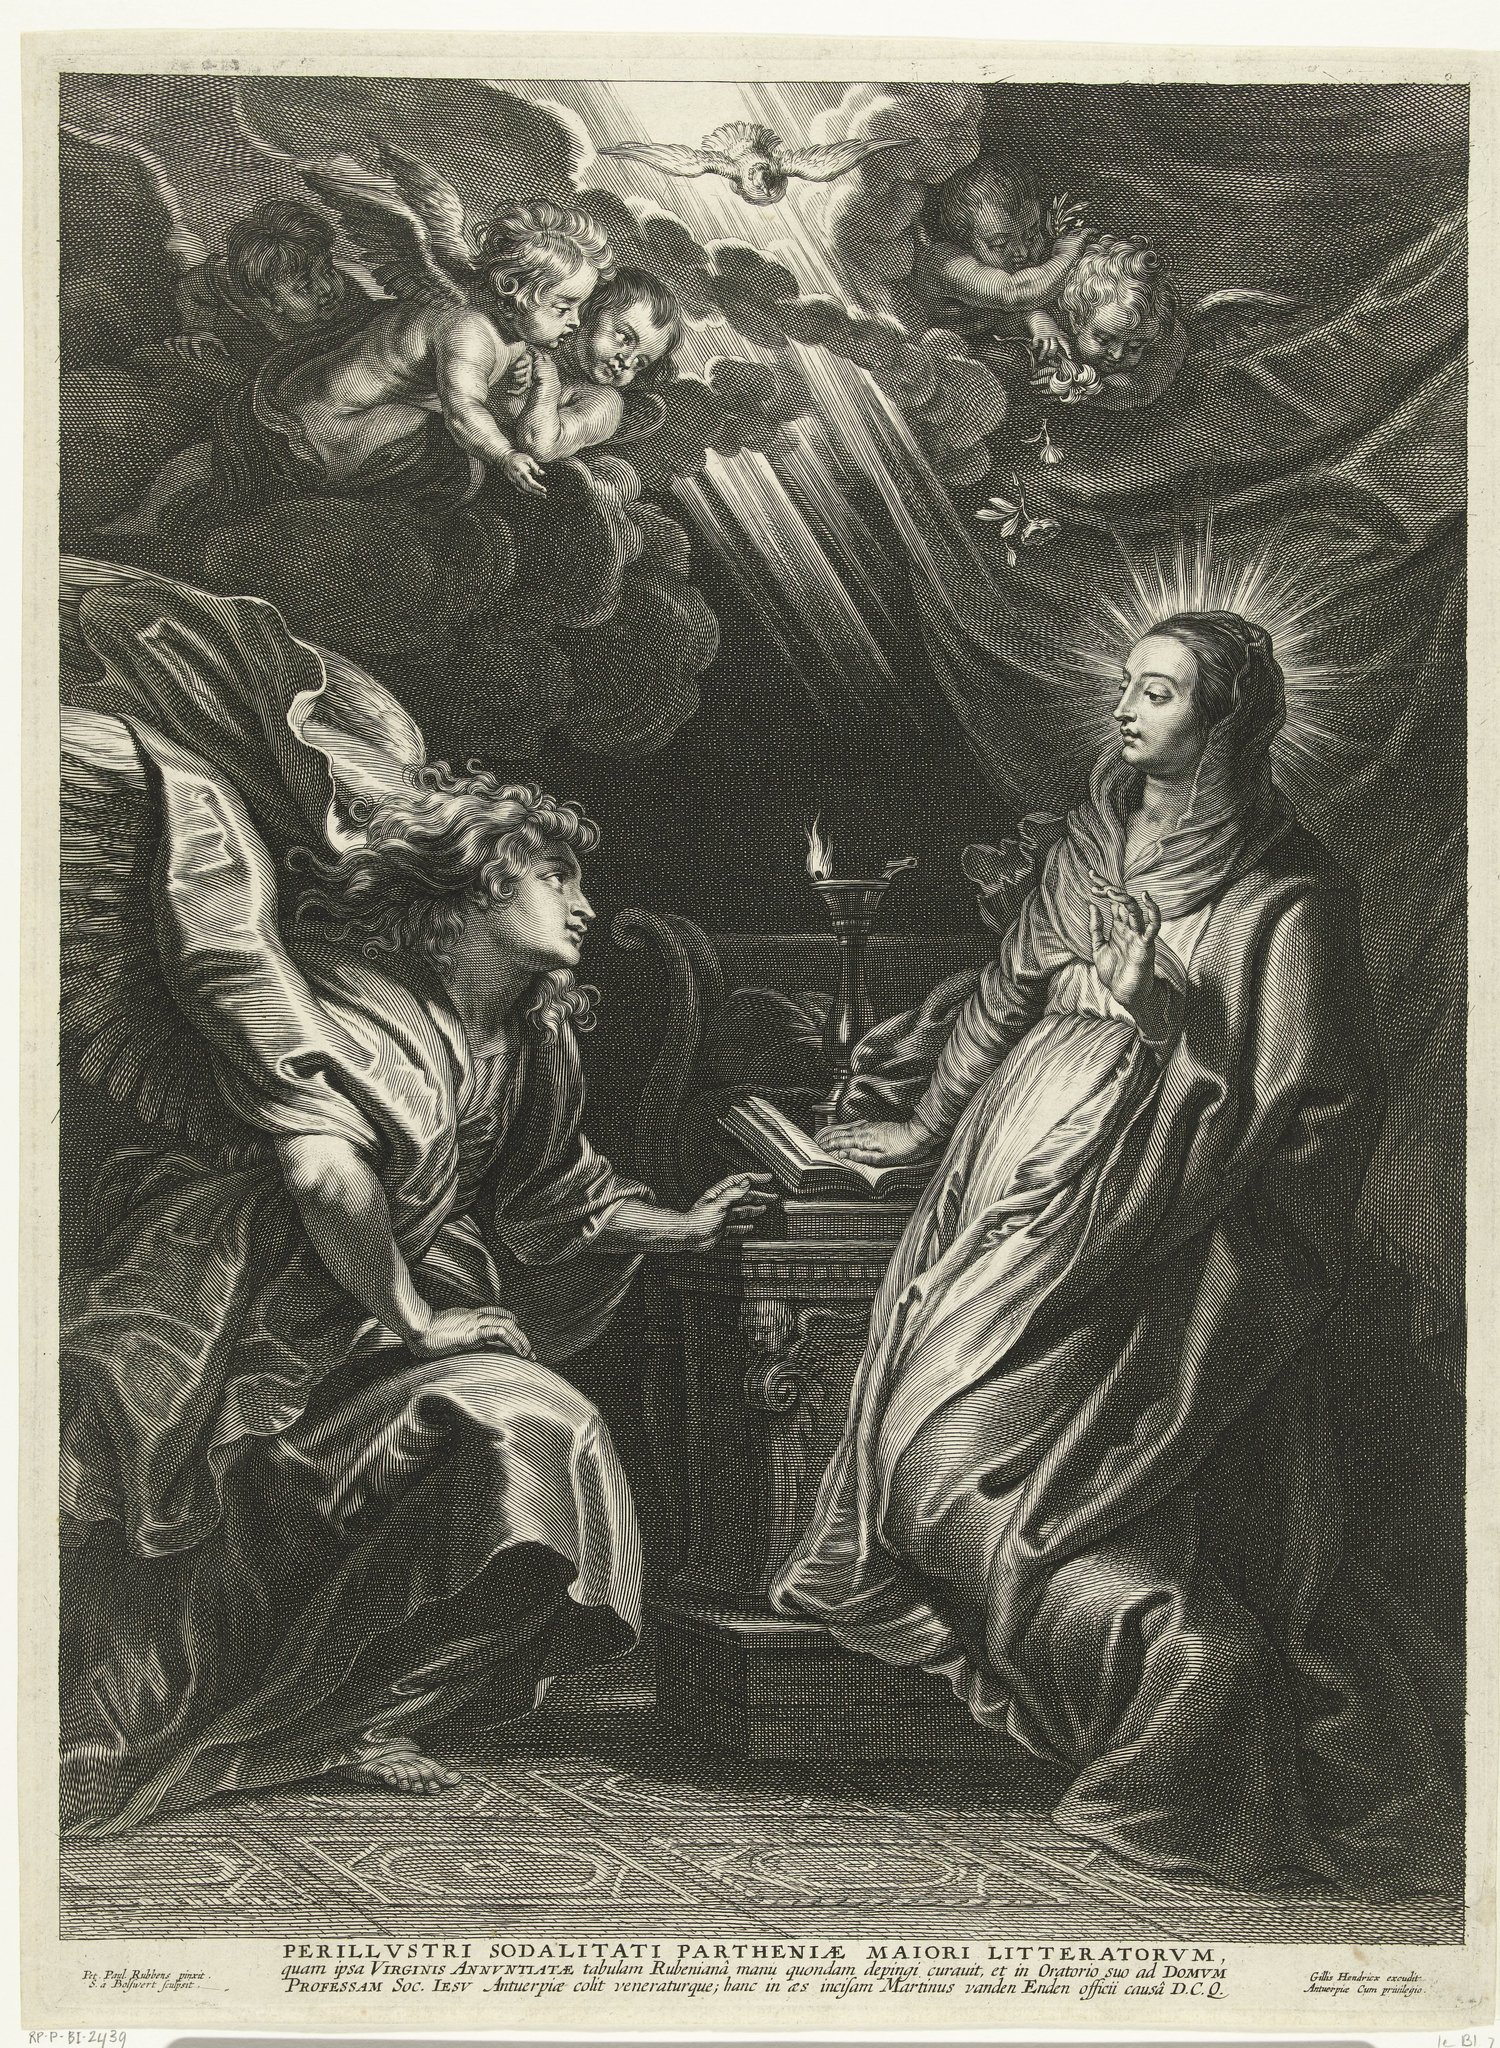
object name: print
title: Annunciatie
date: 1596-1659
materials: paper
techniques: engraving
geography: antwerp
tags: the annunciation: mary kneeling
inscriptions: collector's mark: Lugt 240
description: Prent naar schilderij van Peter Paul Rubens.